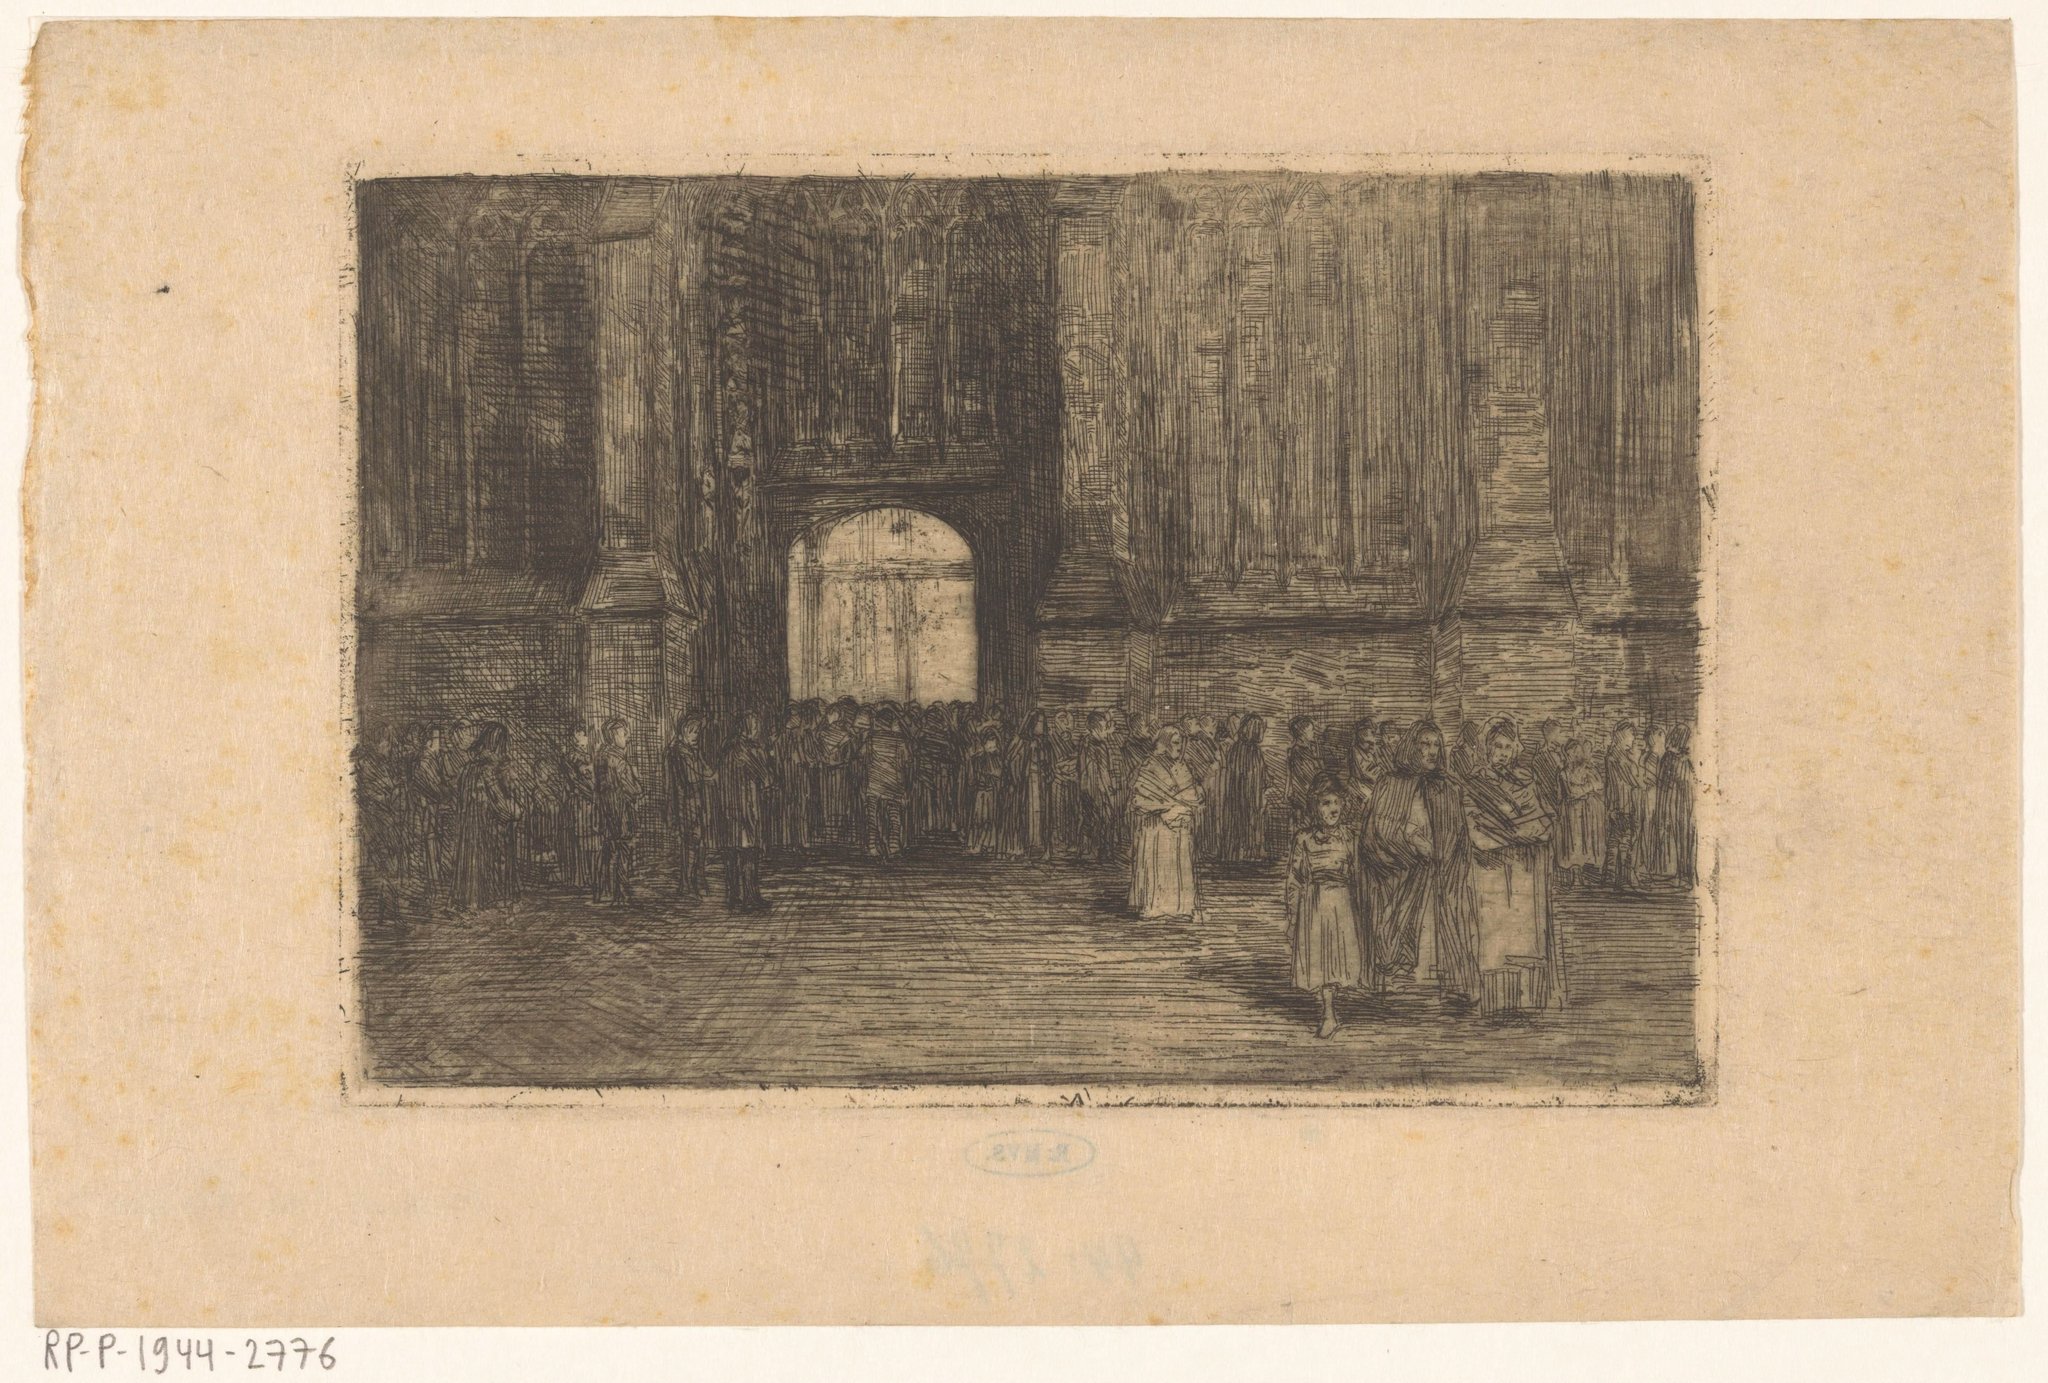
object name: print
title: Kerkportaal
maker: antoon derkinderen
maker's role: draughtsman, painter, print maker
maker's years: 1859-1925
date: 1869-1925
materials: paper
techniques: etching, intaglio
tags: parts of church exterior and annexes: portal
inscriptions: collector's mark: Lugt 2228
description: Mensen betreden en verlaten een kerk door een portaal.